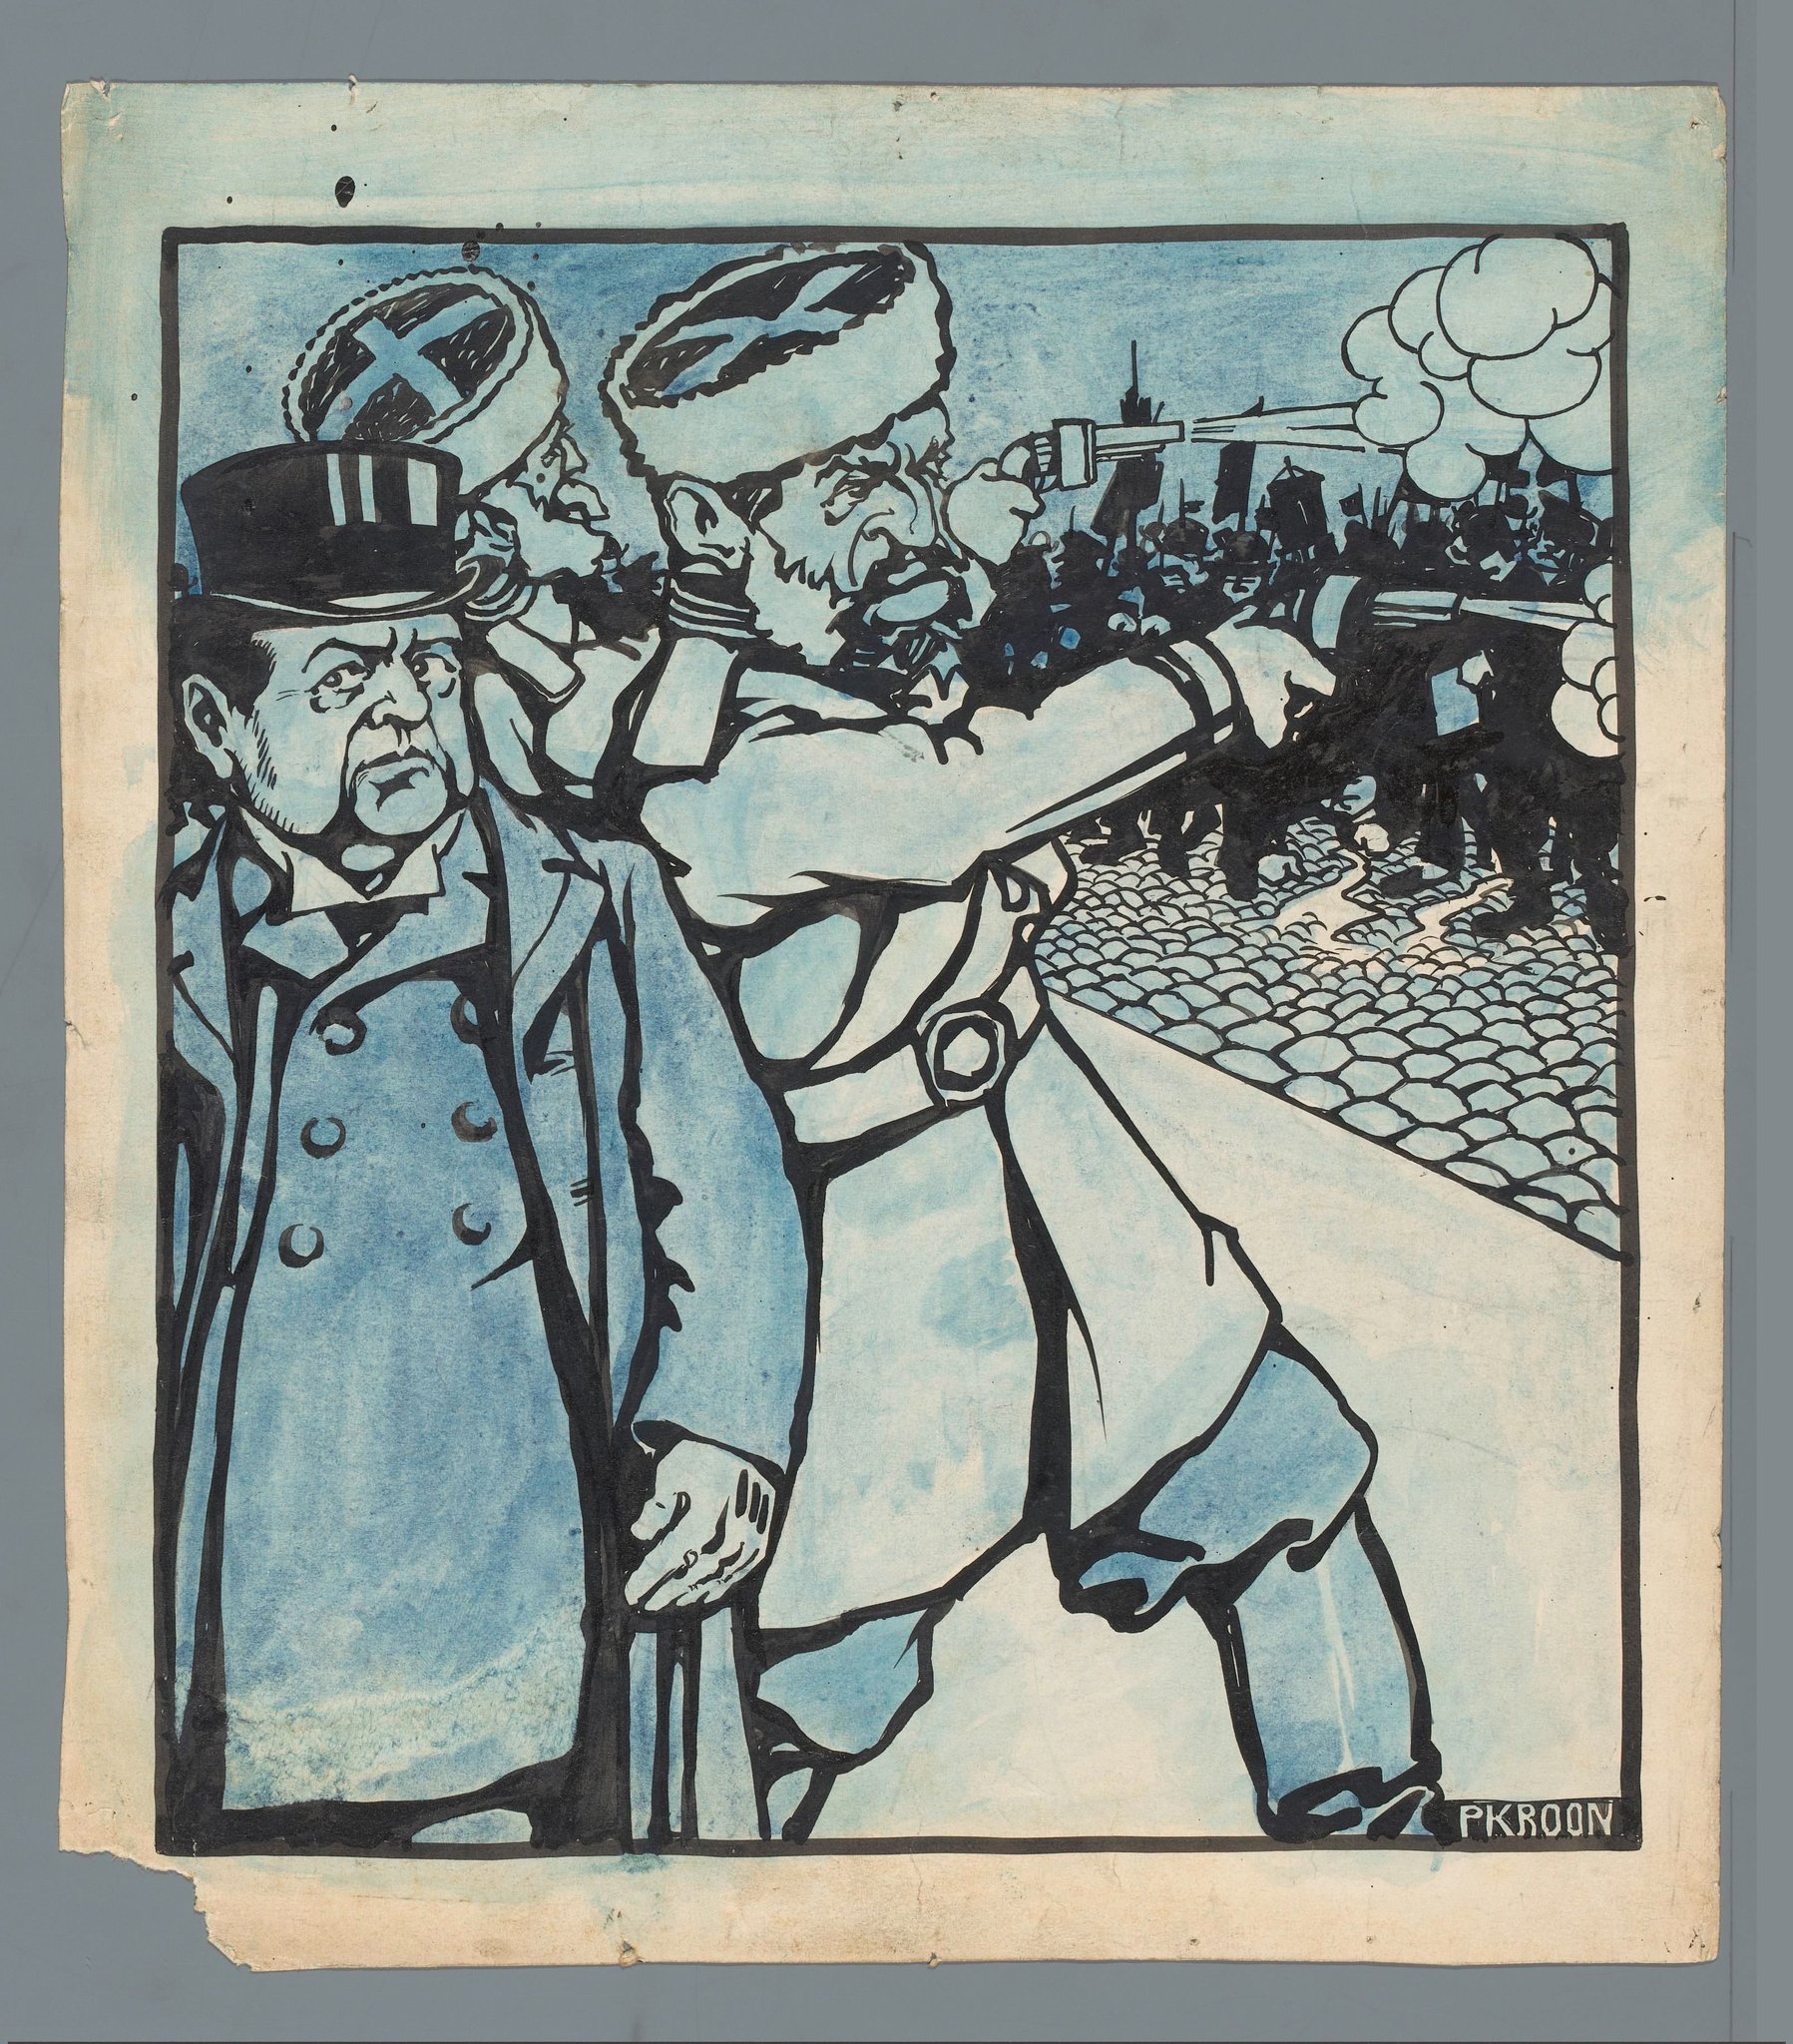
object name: drawing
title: Abraham Kuyper en politie die op demonstranten schiet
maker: patricq kroon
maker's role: draughtsman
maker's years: 1862-1941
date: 1900-1920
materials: ink, paint, paper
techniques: brush, pen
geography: netherlands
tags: abraham kuyper, revolution, revolt, political caricatures and satires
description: Abraham Kuyper met achter hem enkele mannen met bontmutsen (politie of soldaten) die met pistolen vuren op demonstranten. Mogelijk naar aanleiding van de Russische Revolutie in 1917. Ontwerp voor een politieke spotprent.